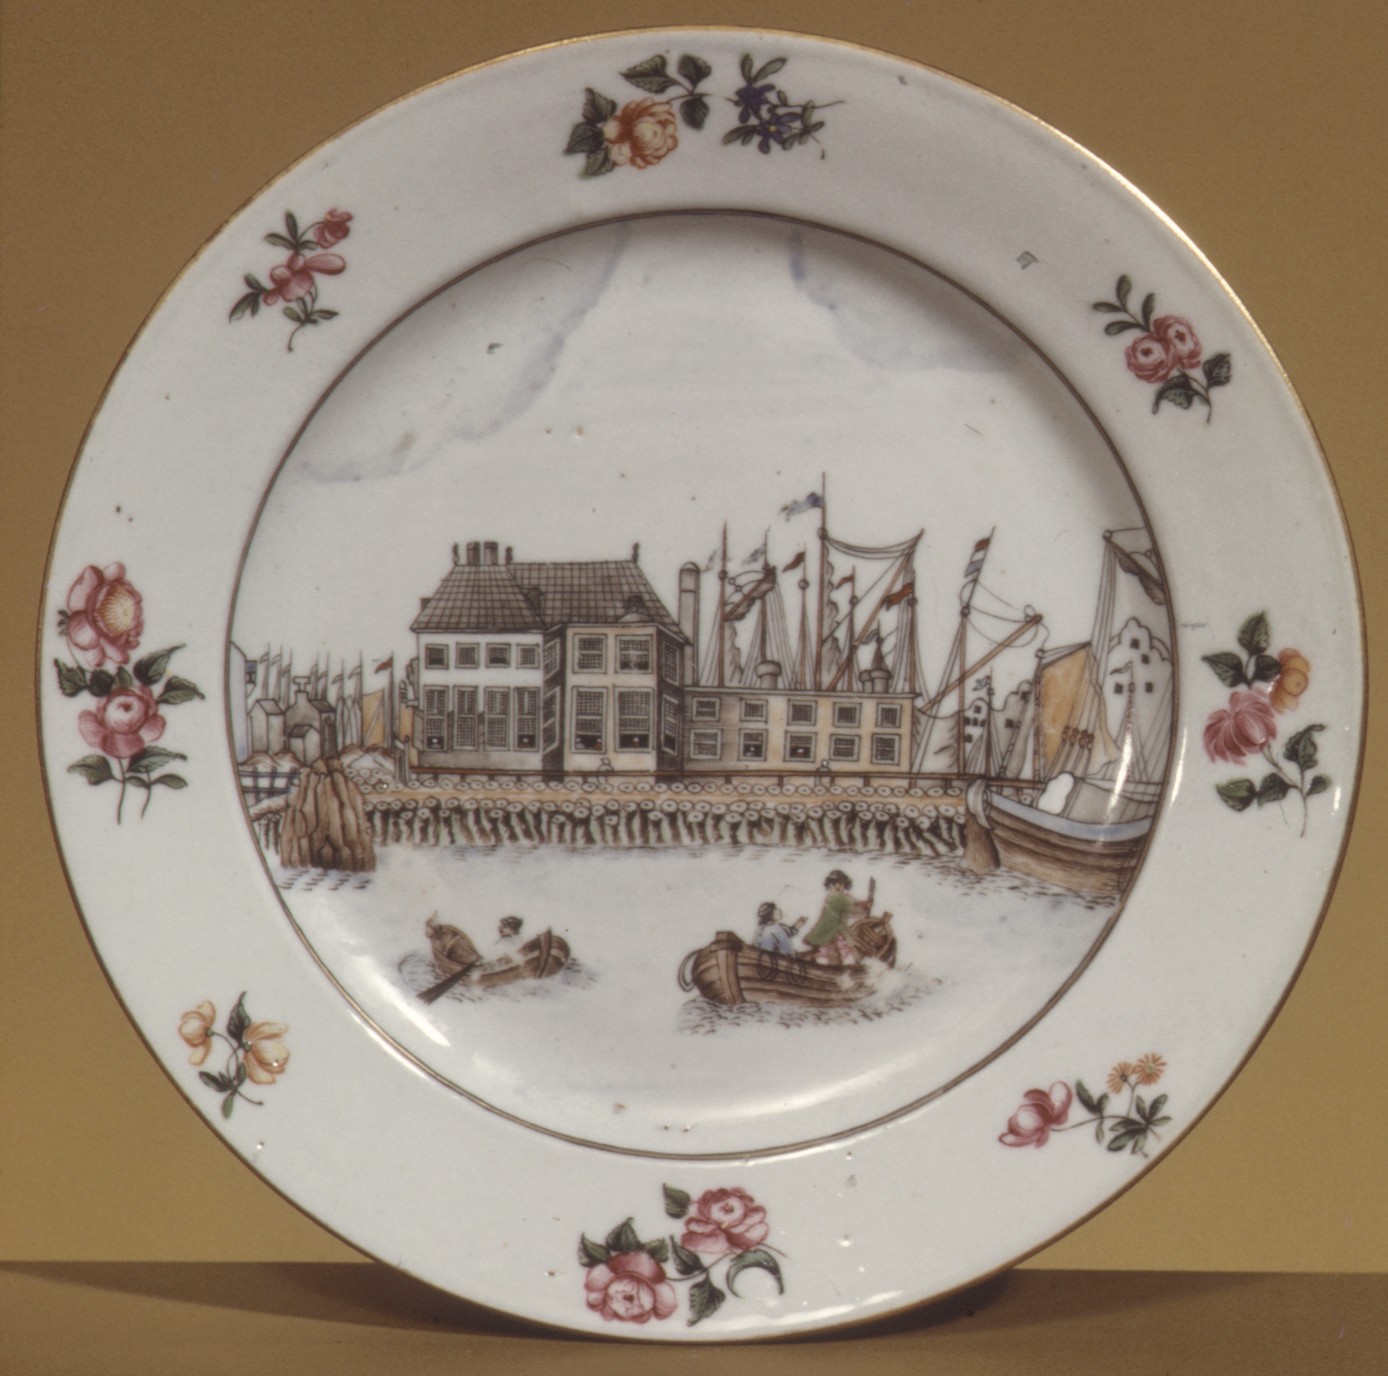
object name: plate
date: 1760-1765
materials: hard paste porcelain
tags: buildings,boats